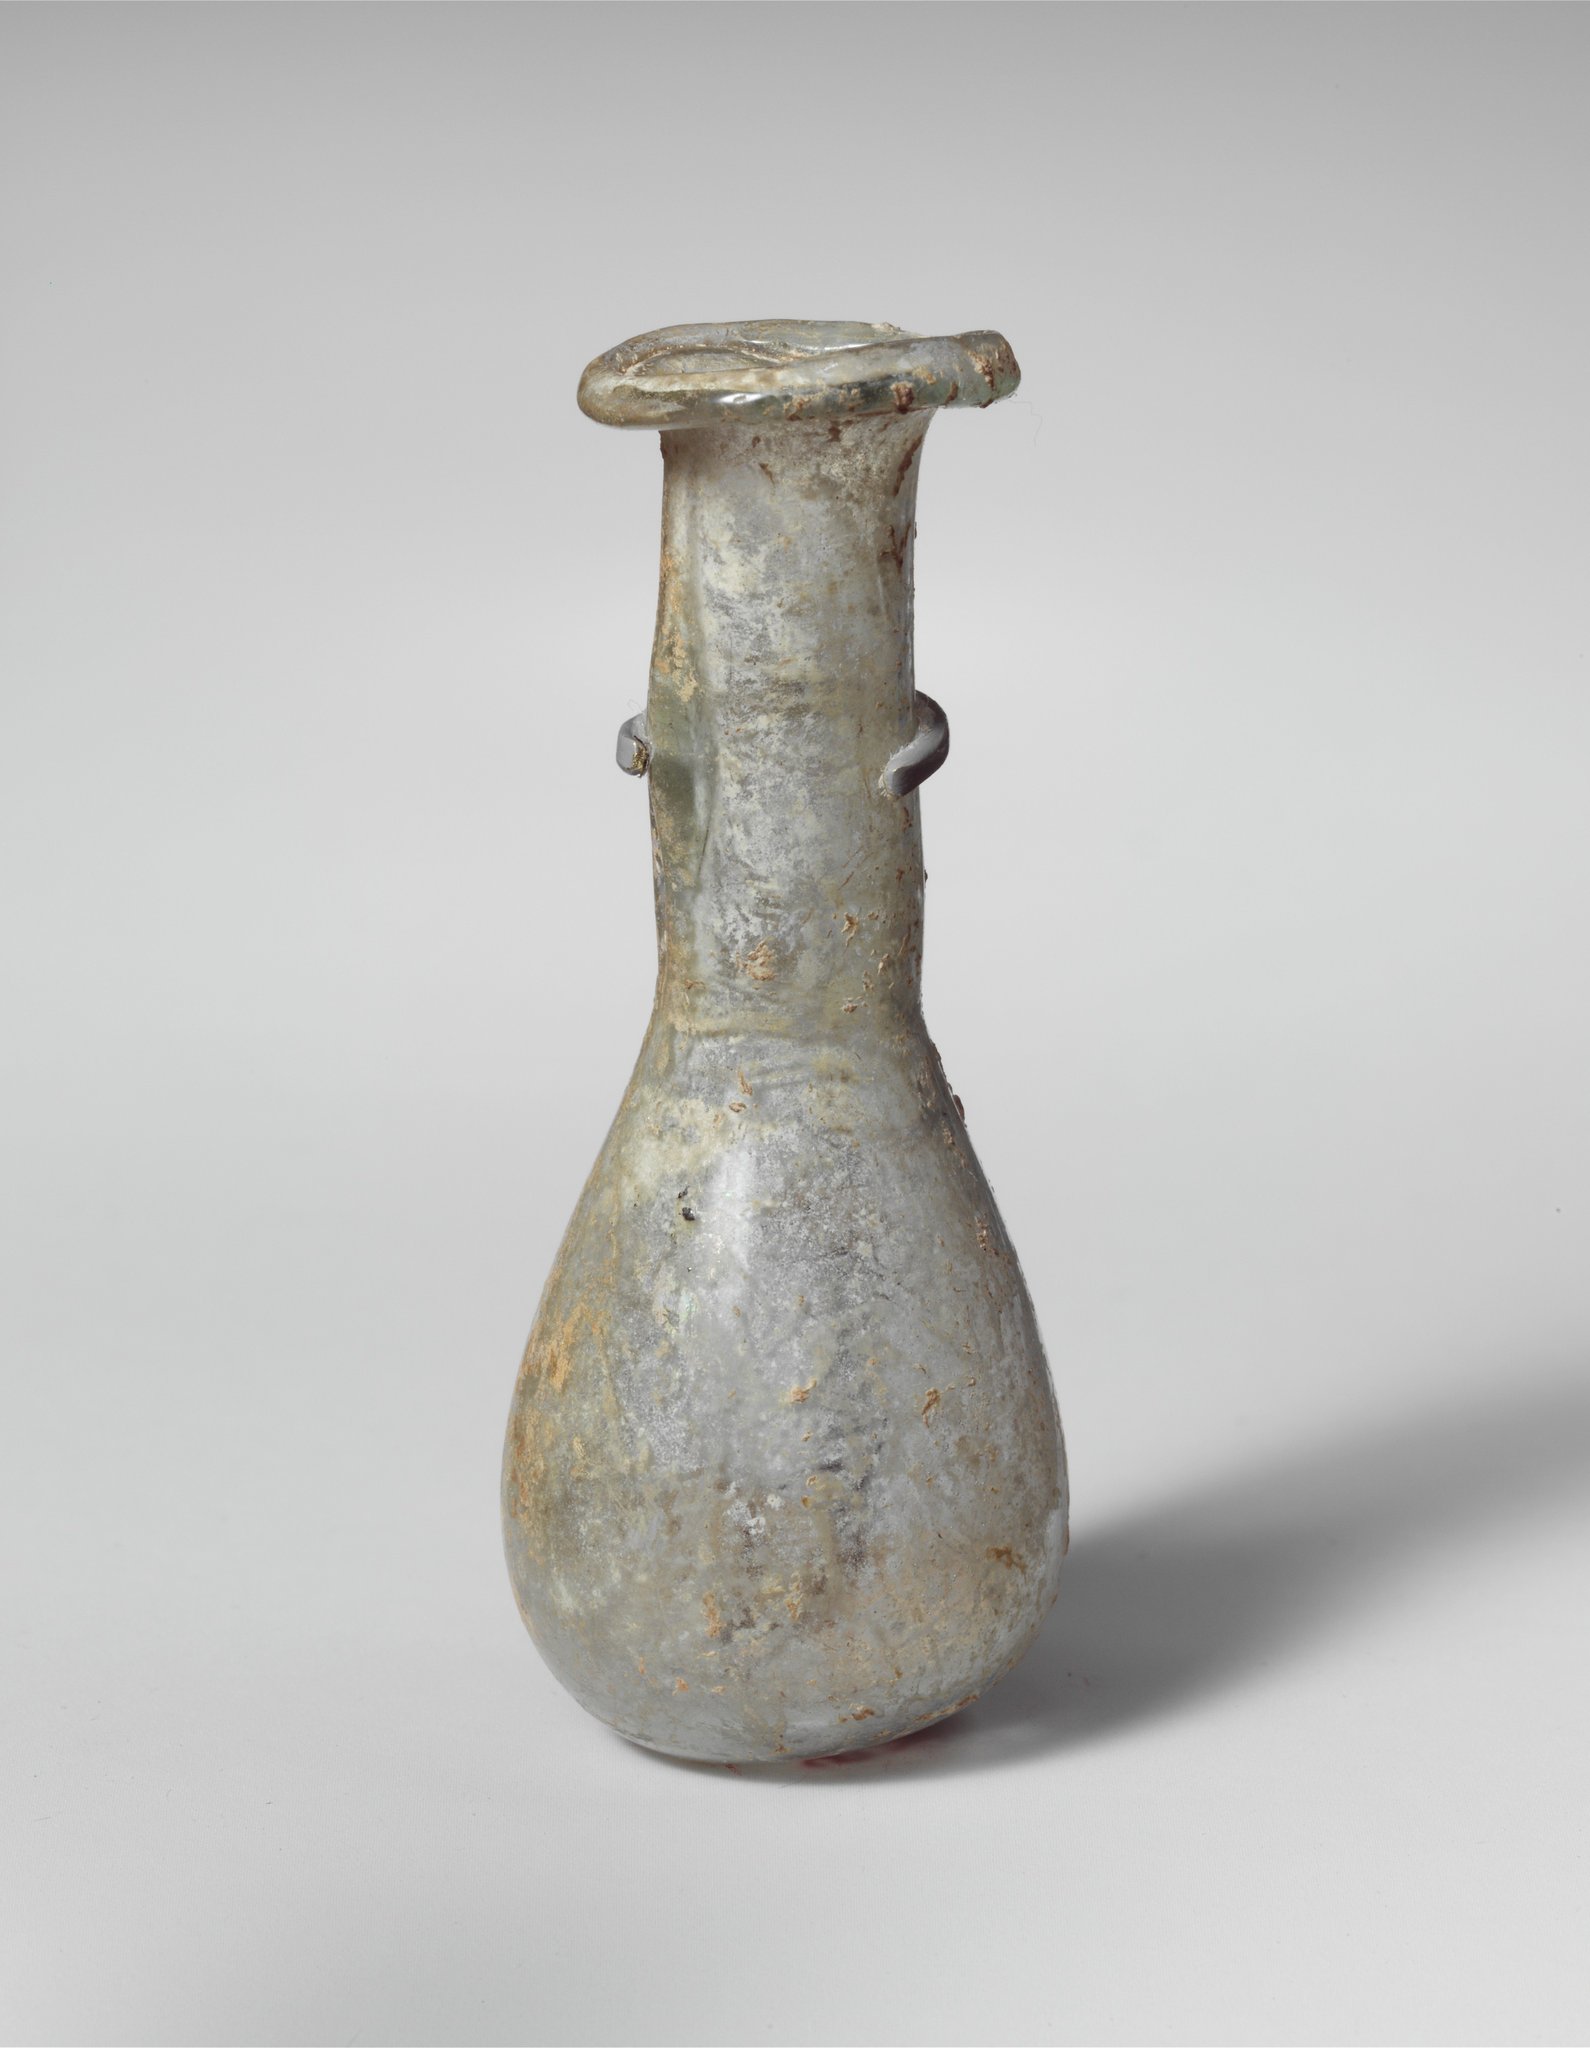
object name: perfume bottle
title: Glass perfume bottle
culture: roman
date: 1-200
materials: glass